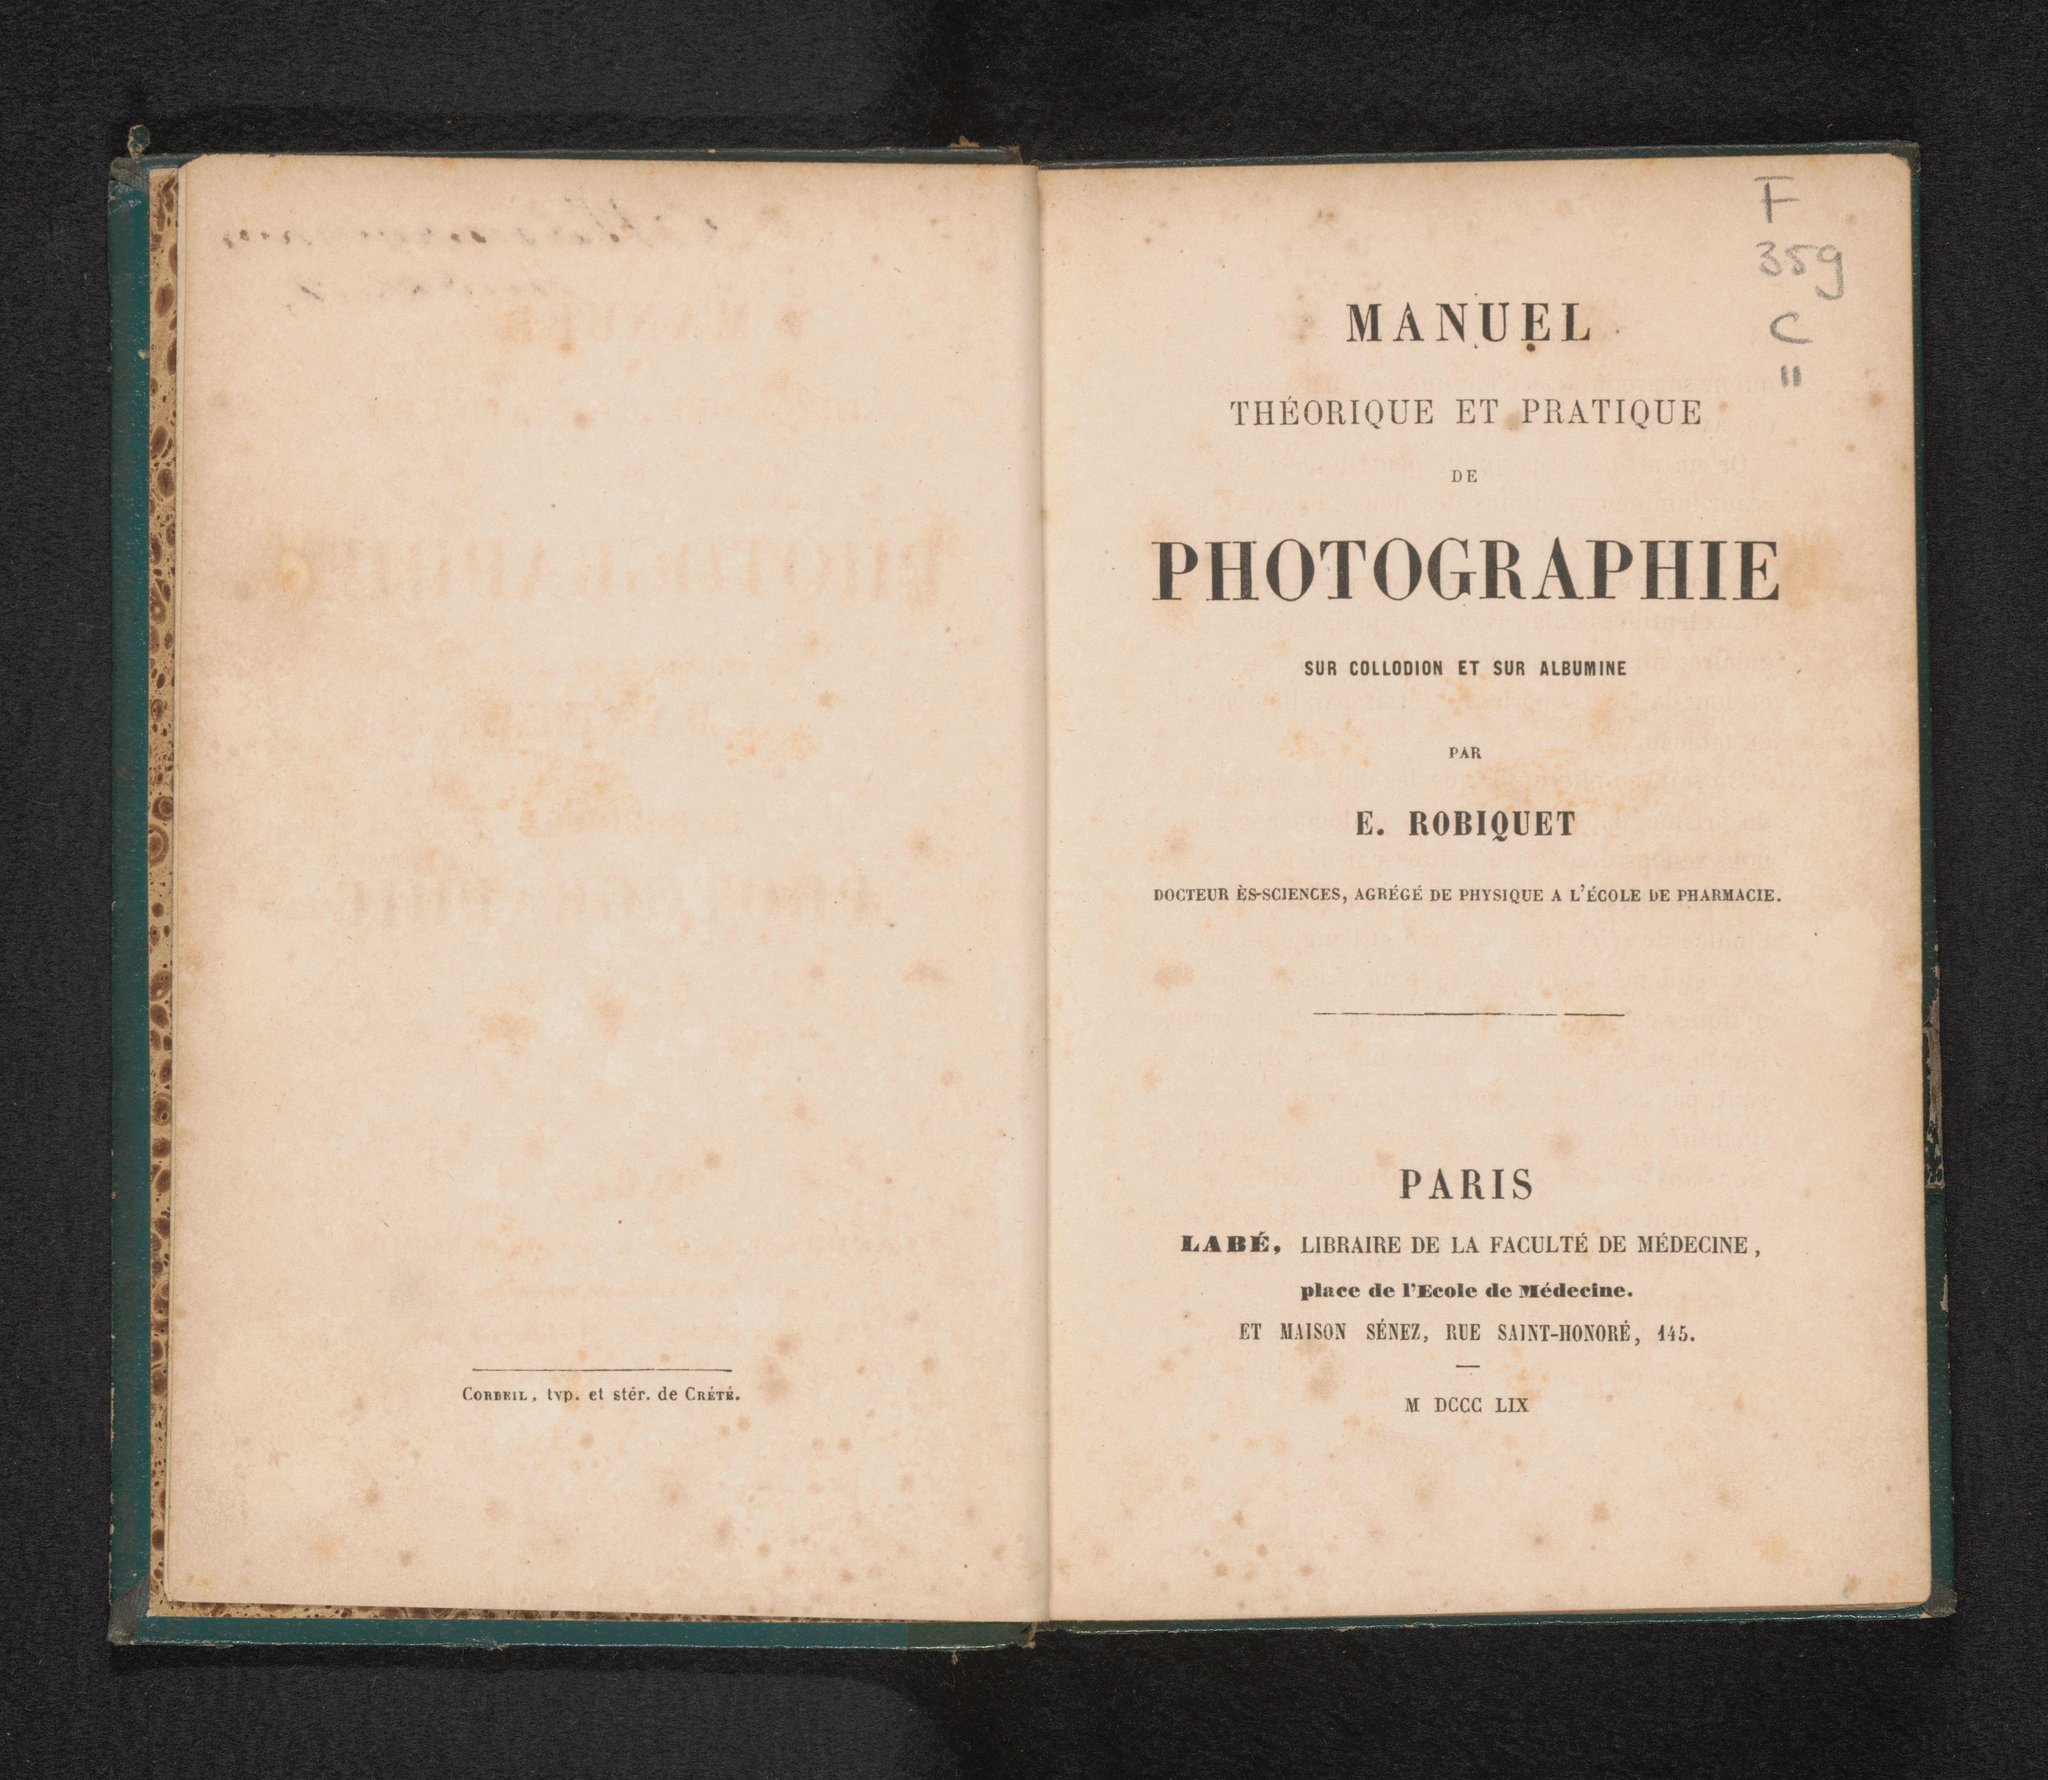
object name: book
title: Manuel théorique et pratique de photographie sur collodion et sur albumine / E. Robiquet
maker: henri edmond robiquet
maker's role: auteur, fotograaf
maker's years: 1822-1860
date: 1859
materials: cardboard, linen, paper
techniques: carbon print, printing, marbled paper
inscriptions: annotation: ‘APR/ 1989’